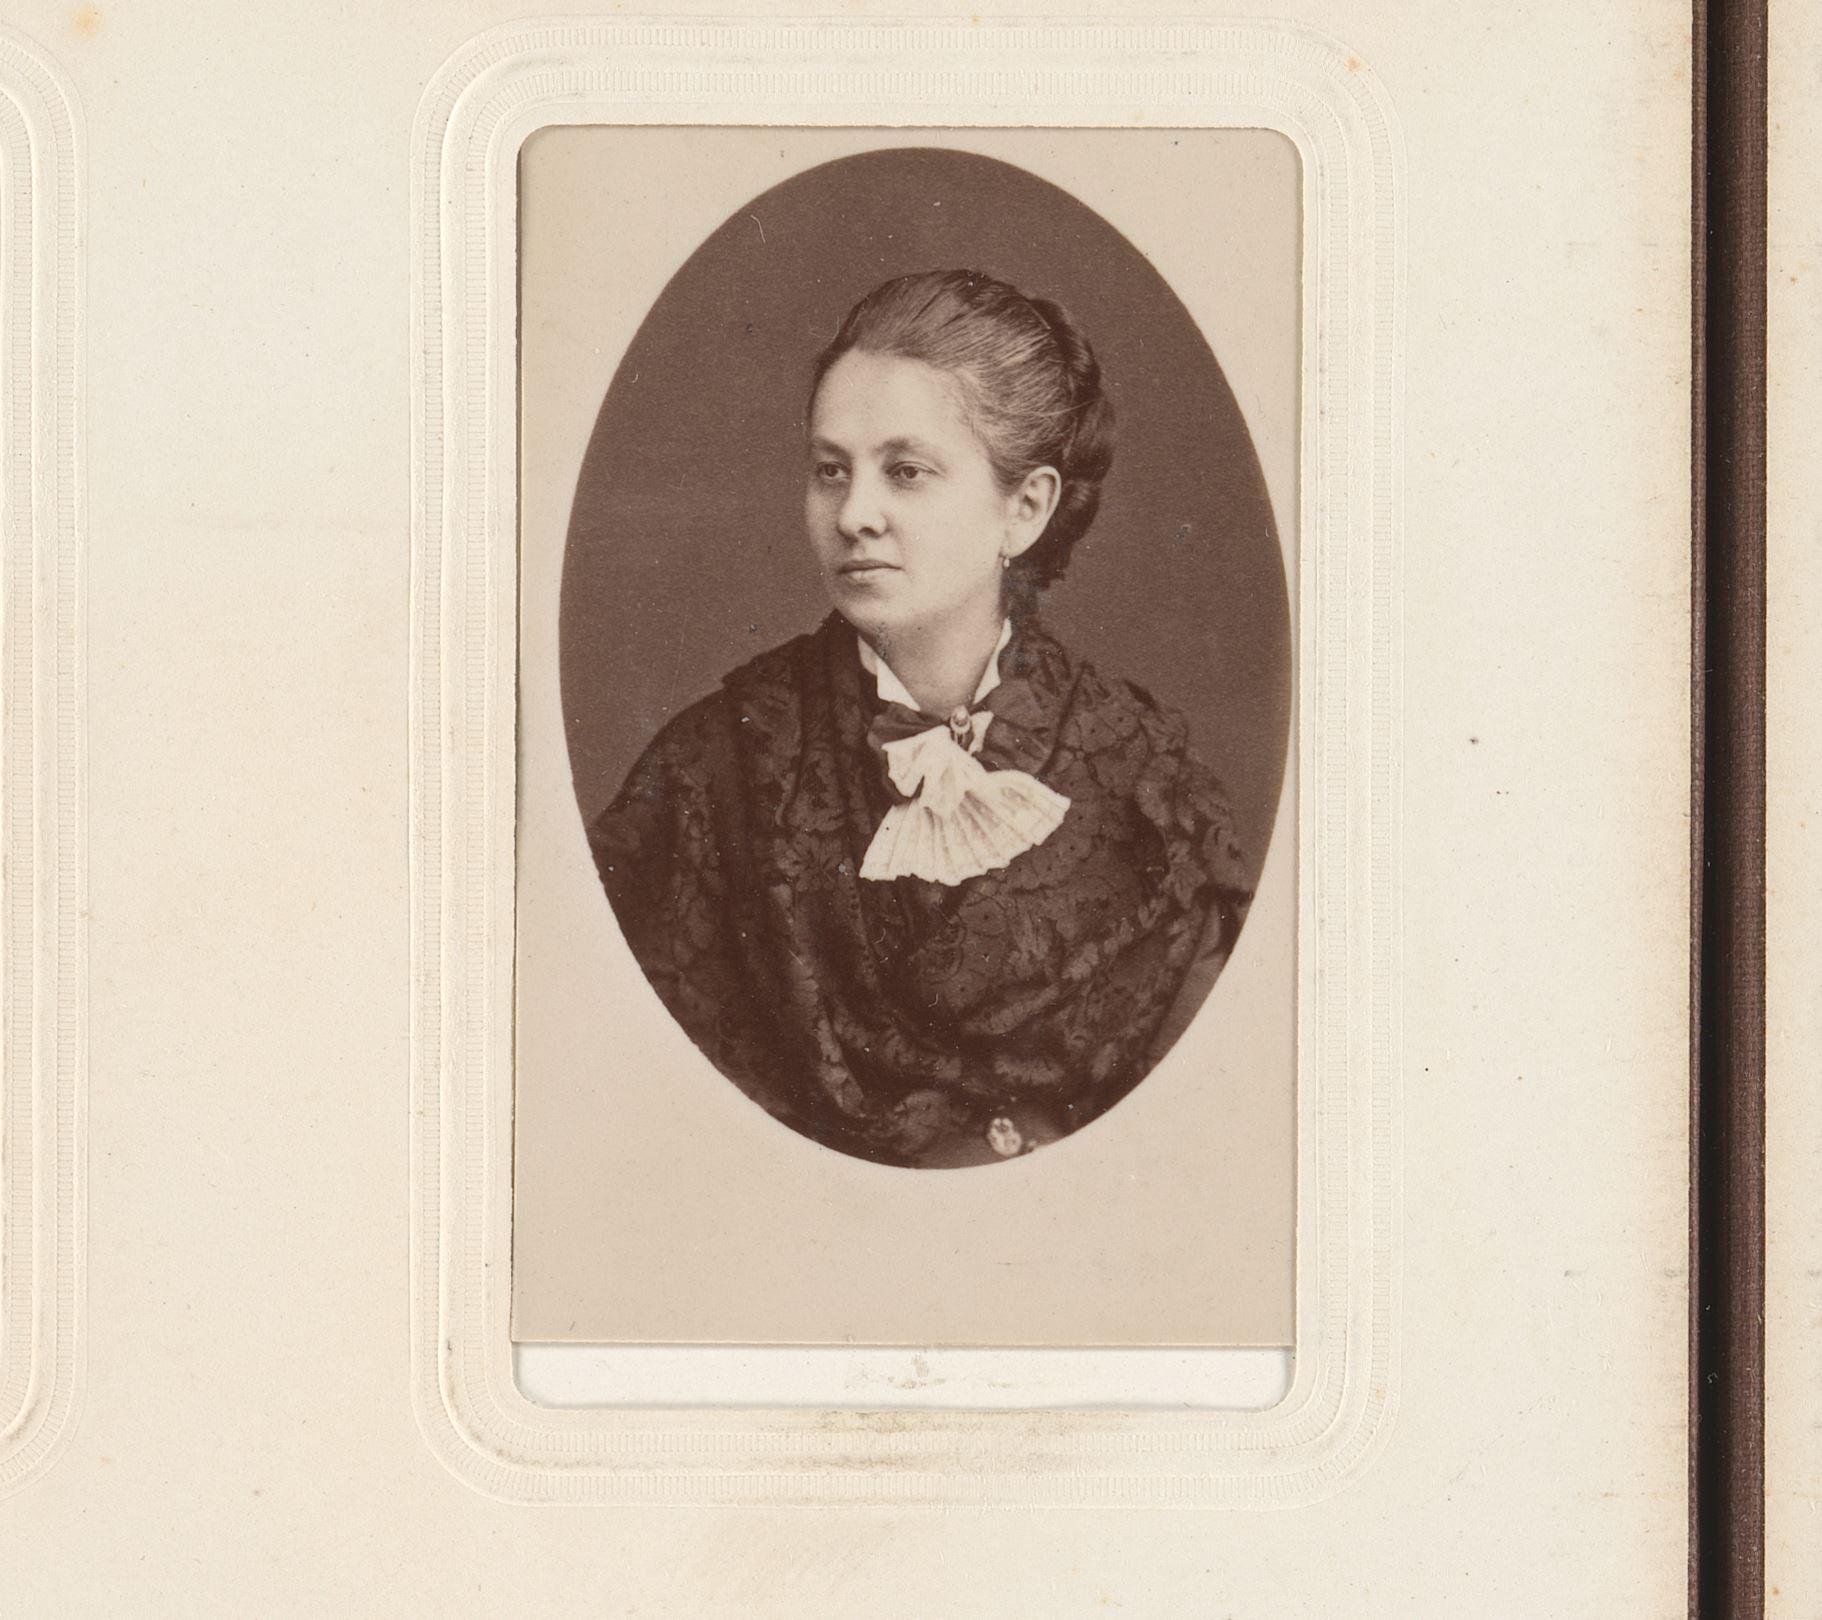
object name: semi enamel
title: Portret van een vrouw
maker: Anonymous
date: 1880-1900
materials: cardboard, celluloid, paper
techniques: albumen print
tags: historical persons - bb - woman